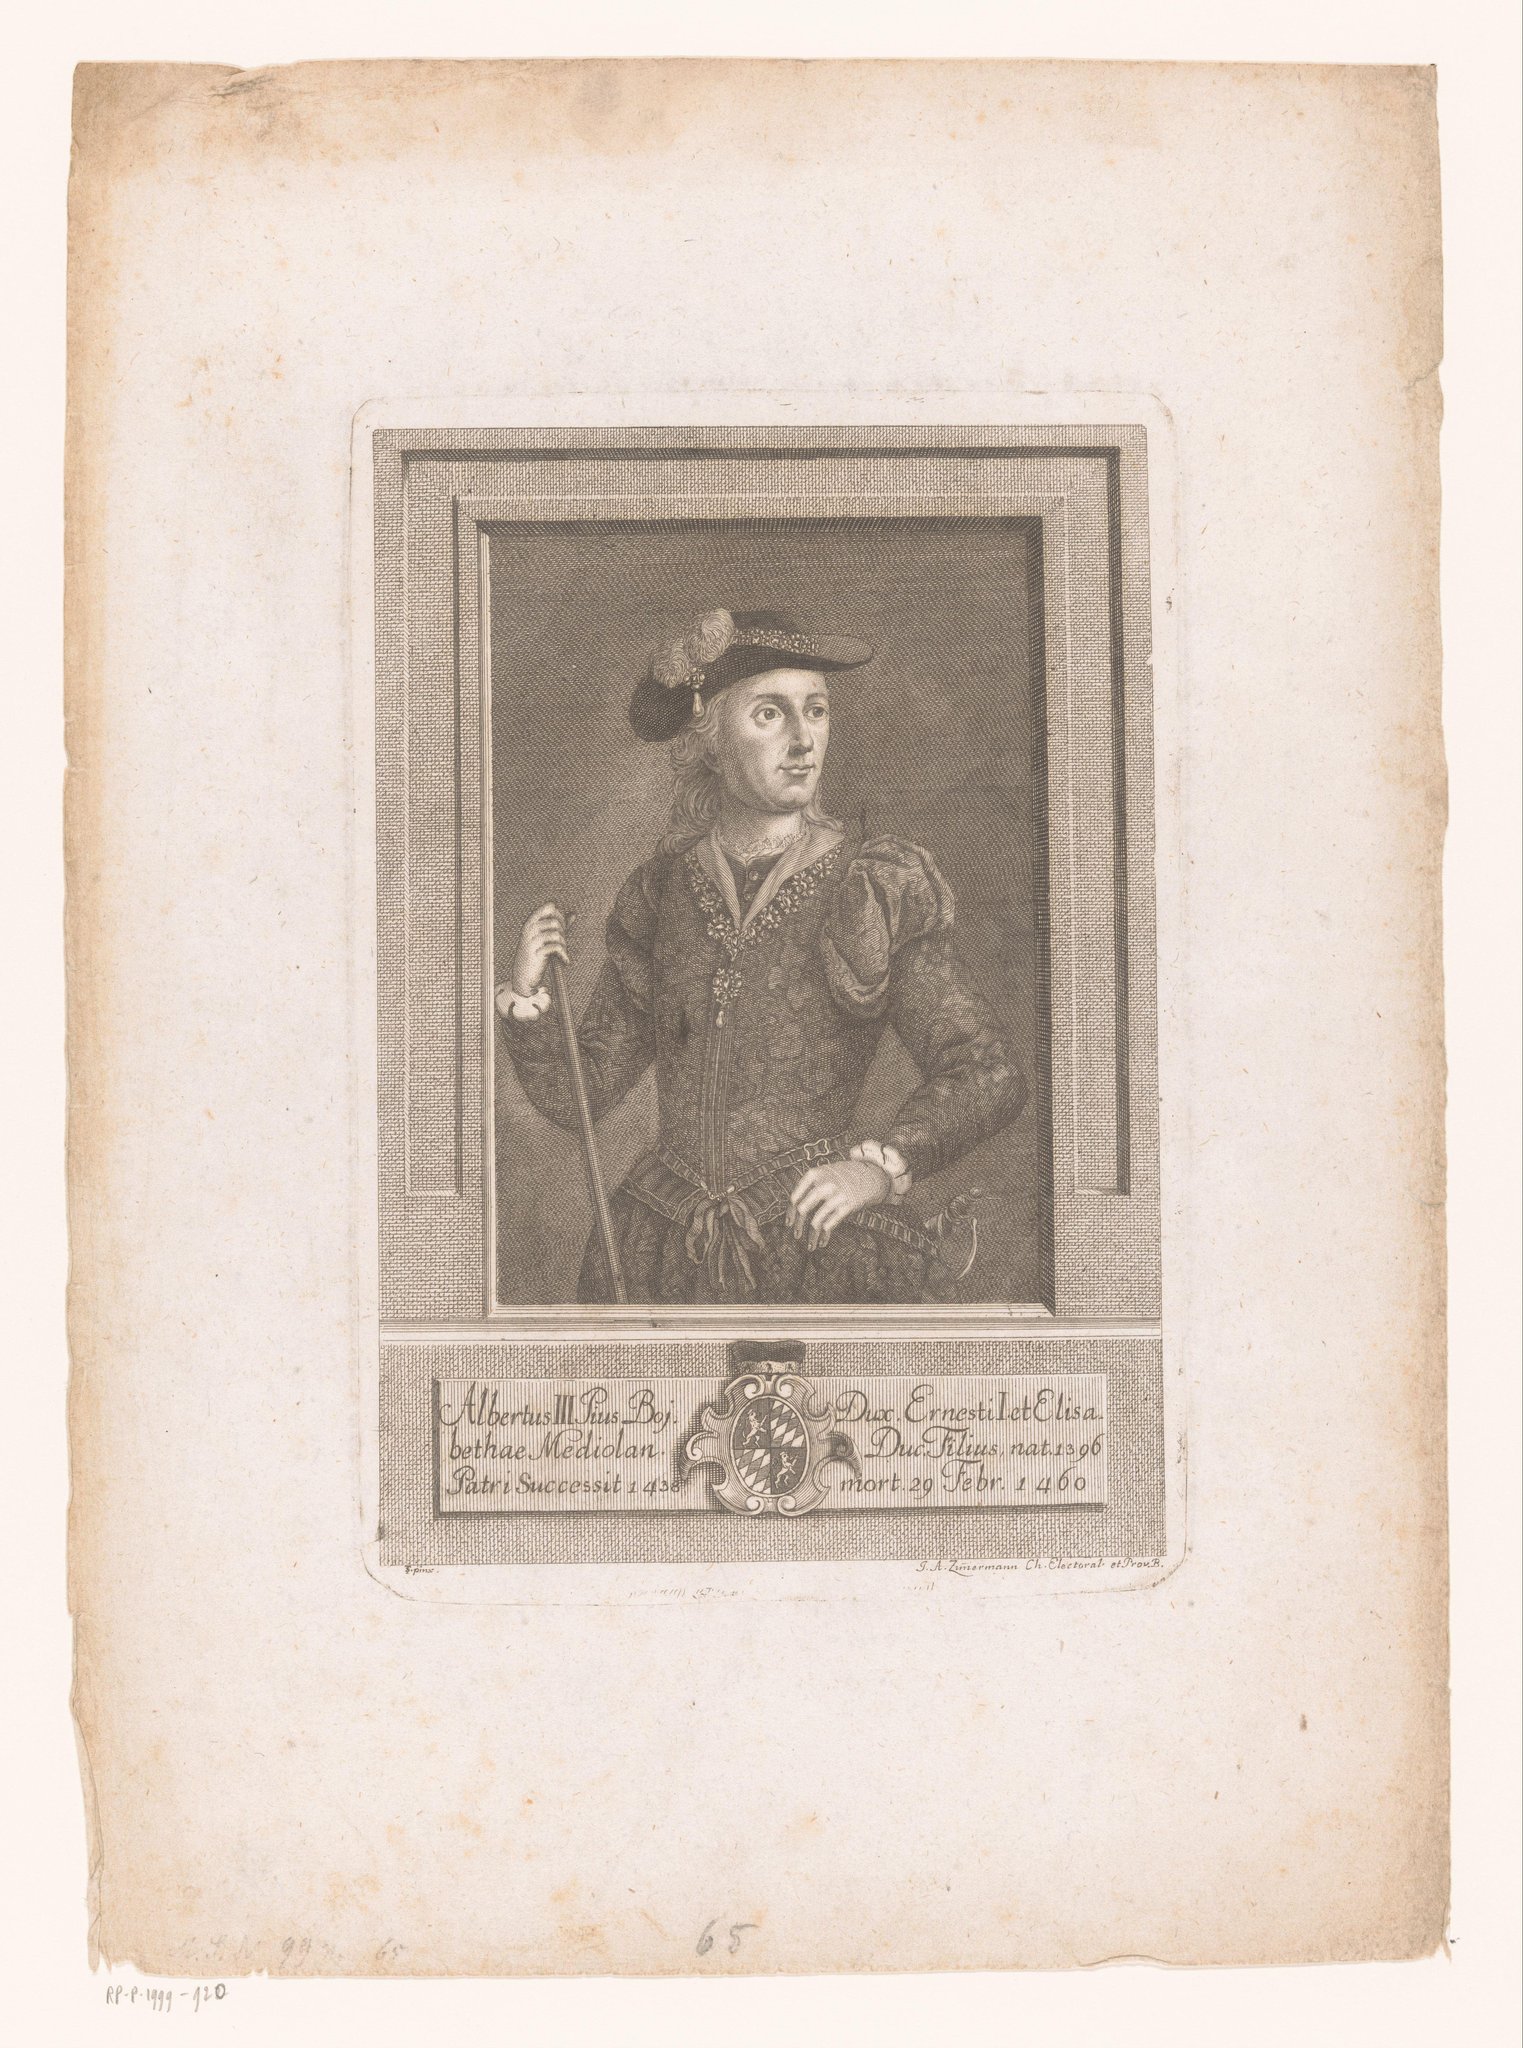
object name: print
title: Portret van Albrecht III van Beieren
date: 1773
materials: paper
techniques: engraving, etching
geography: germany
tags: historical persons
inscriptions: collector's mark: Lugt 2760, collector's mark: Lugt 2228, collector's mark: Lugt 4100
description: Prent gebruikt voor de publicatie: Zimmermann, Joseph Anton. Series Imaginum Augustae Domus Boicae. München: s.n., 1773.